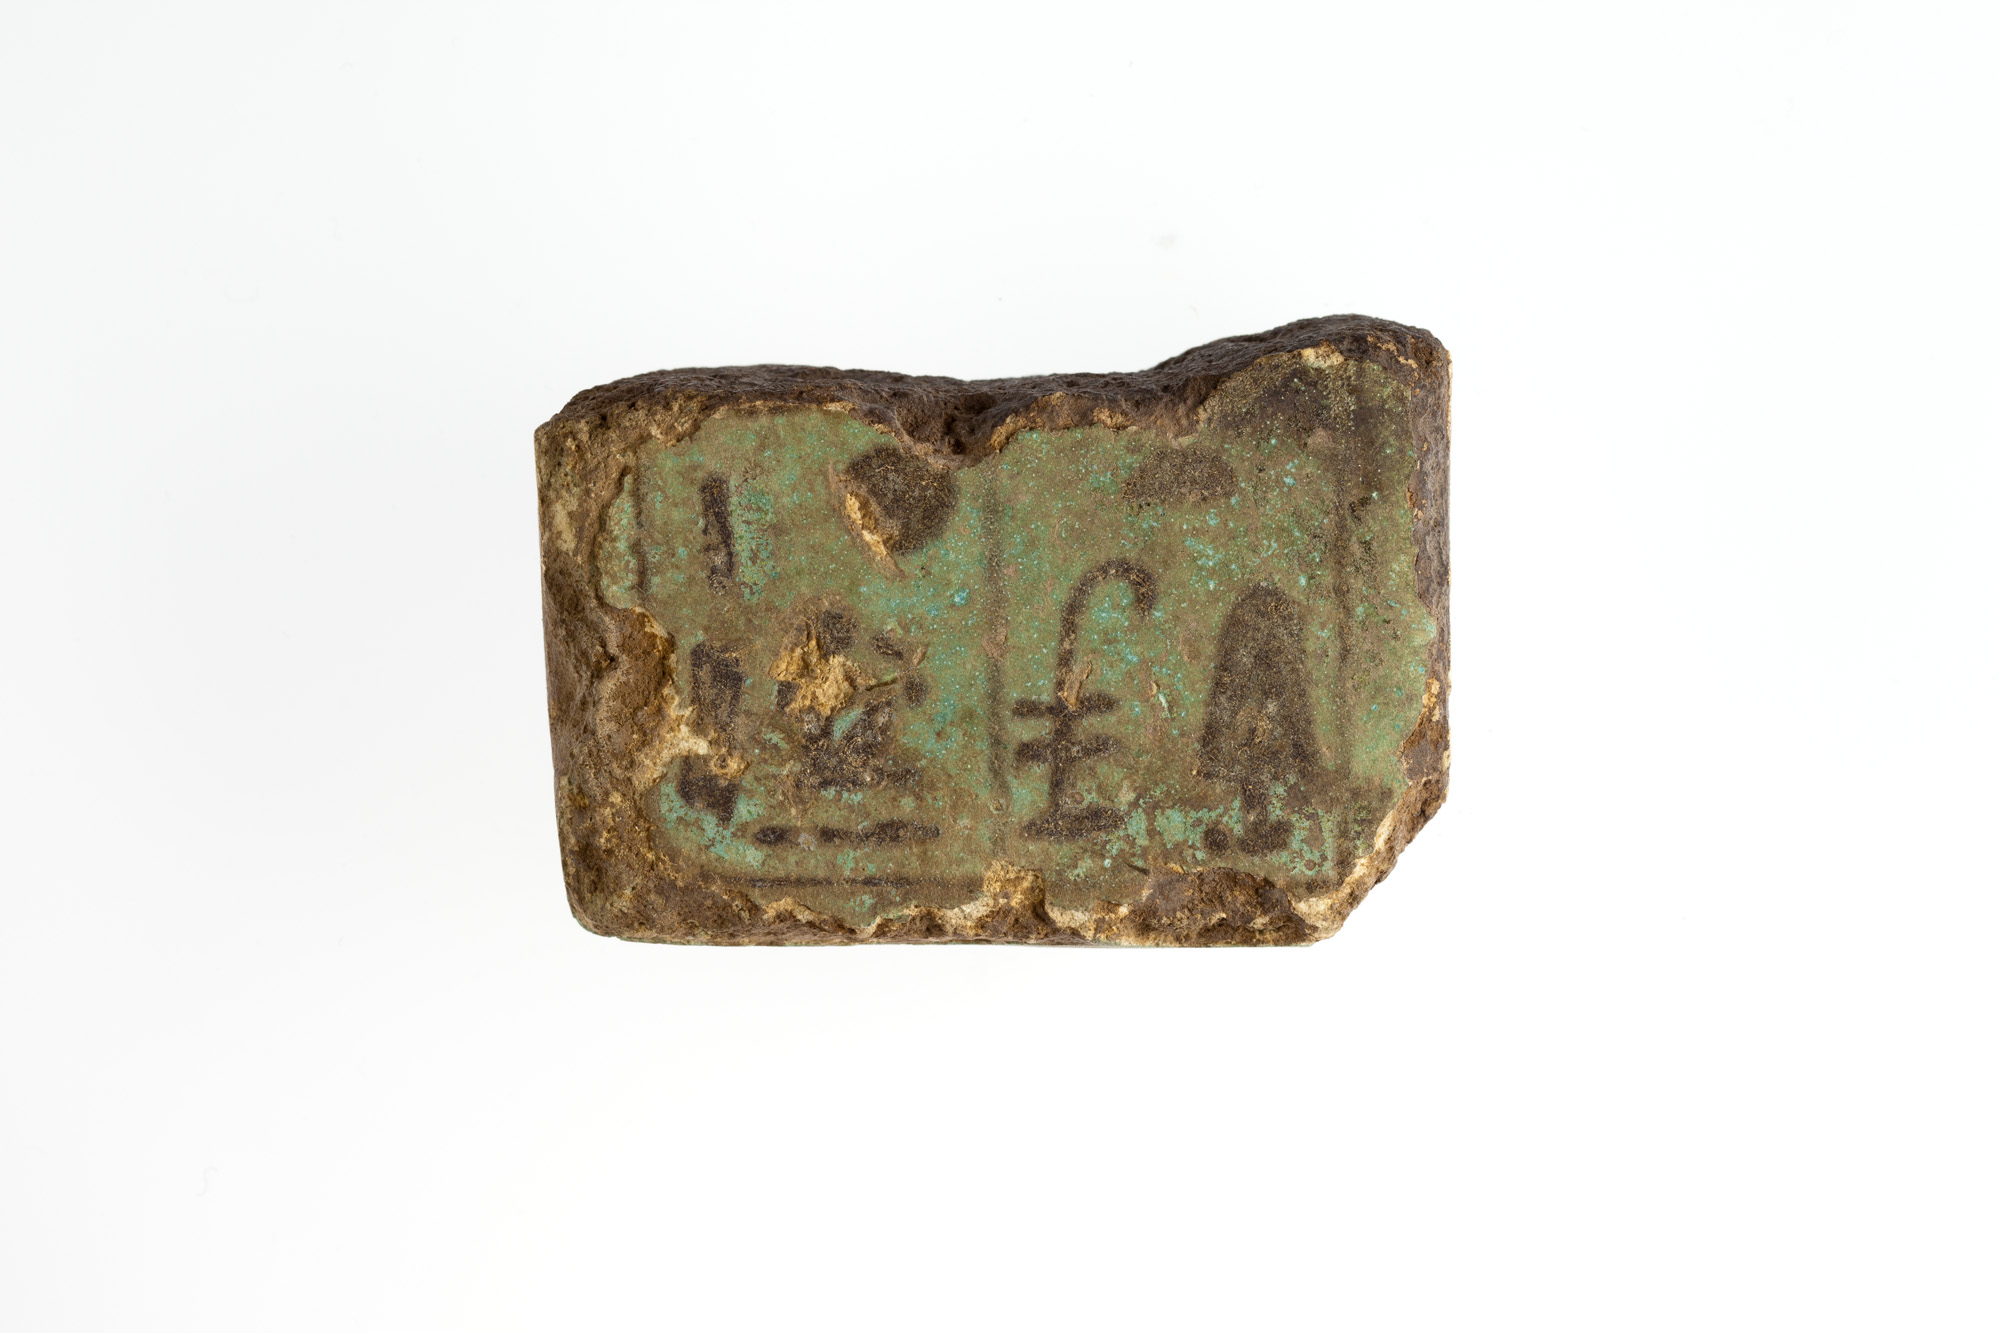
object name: tile fragment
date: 1981-1640 BCE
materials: faience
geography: egypt